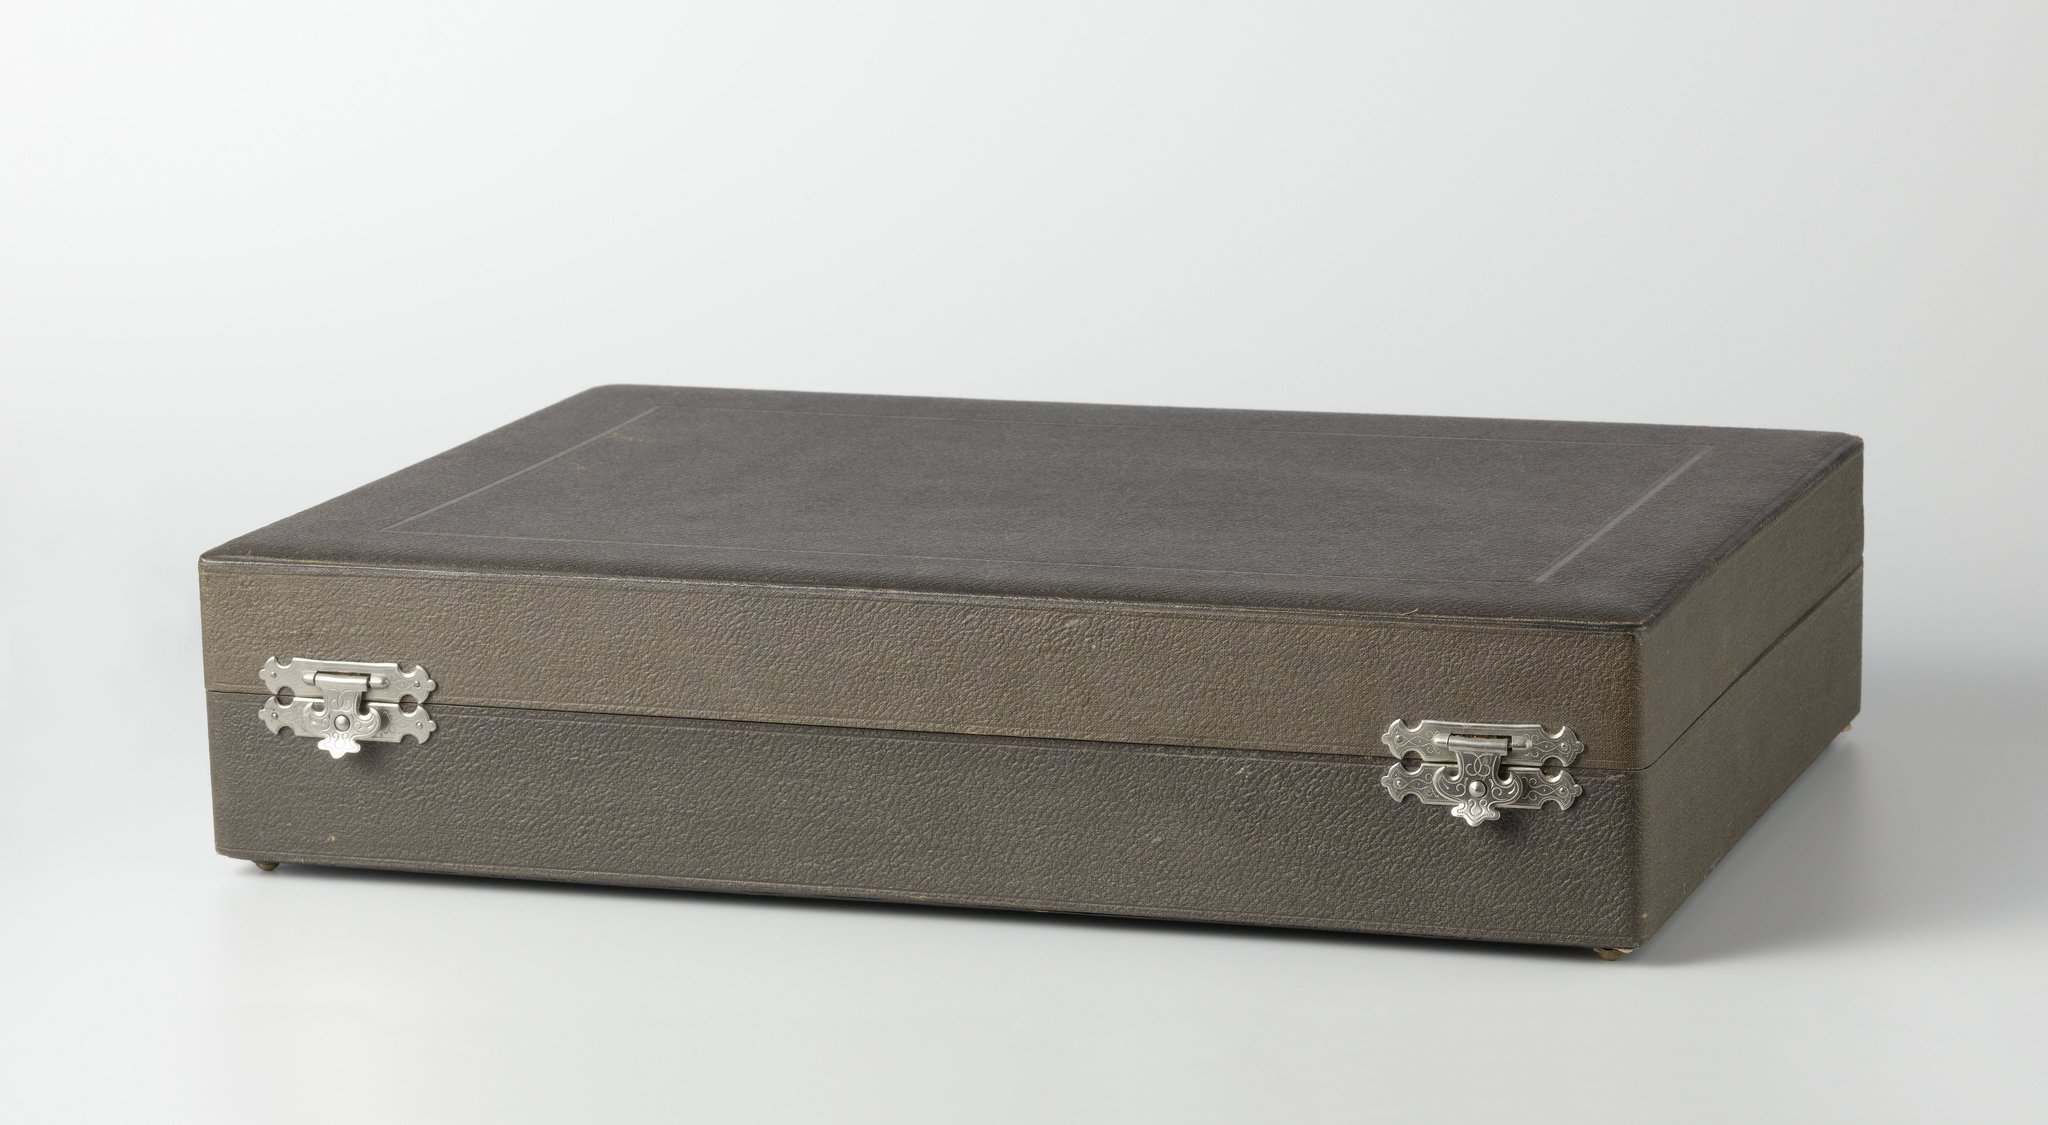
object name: vessel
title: Cassette behorend bij een servies bestaande uit twaalf koppen en schotels, beschilderd met vogels en violen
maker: c.w.j. t hart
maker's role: plateelschilder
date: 1913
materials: leather, silk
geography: the hague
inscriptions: mark: ‘kroon, Rozenburg, ooievaar, den Haag (boven elkaar); links het merk voor 1913, rechts het werkordernummer 332 (op een kop 333); onder het schildersmerk van C.W.J. 't Hart.’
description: Rechthoekige zwarte cassette, gecapittoneerd met beige zijde. De cassette biedt plaats aan twaalf koppen en schotels.